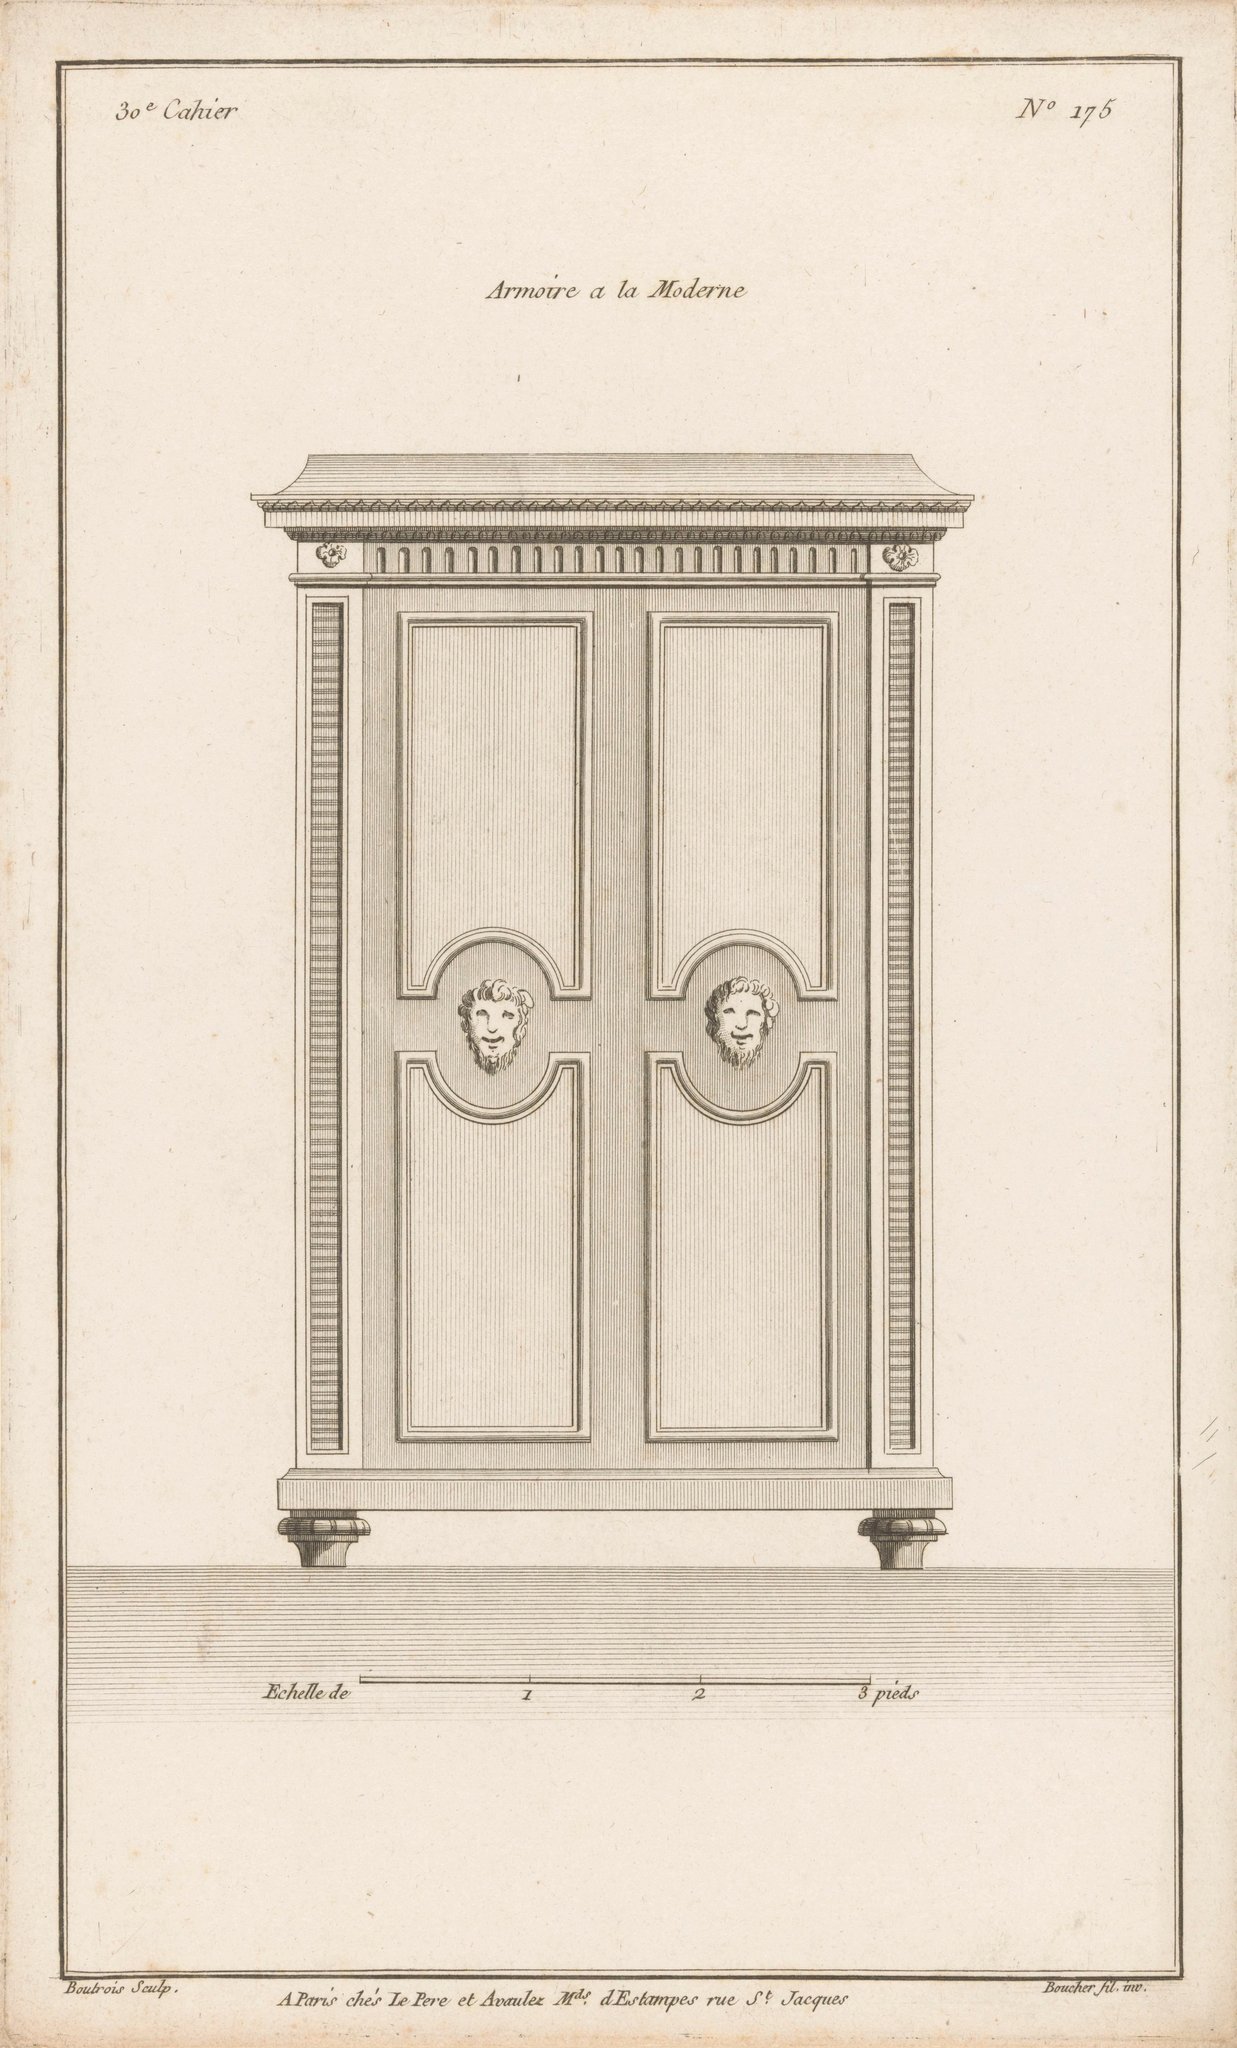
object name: print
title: Kast met maskers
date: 1772-1779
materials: paper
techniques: engraving, etching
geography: paris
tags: furniture for storage, mask, mascaron ~ ornament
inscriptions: collector's mark: Lugt 2760, collector's mark: Lugt 2228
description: Een kast gedecoreerd met mannelijke gezichten. Prentnummer 175.